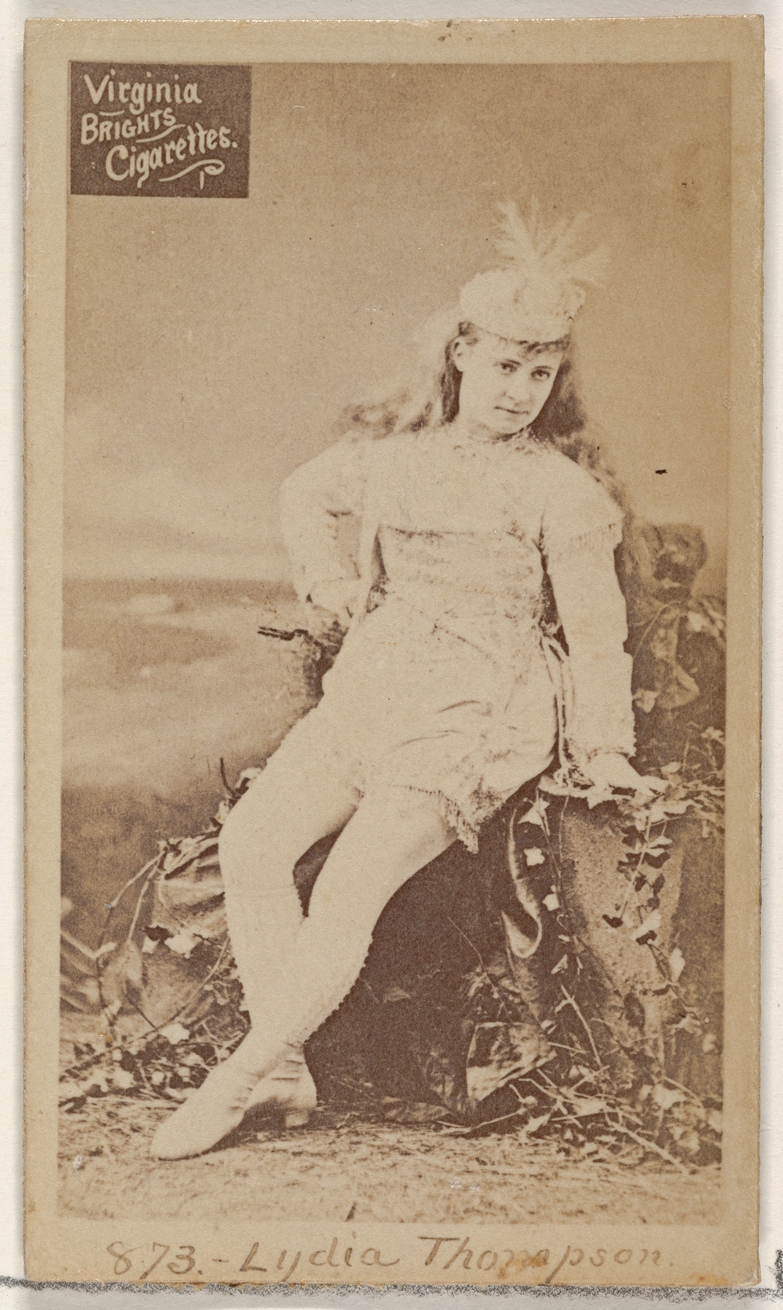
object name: photograph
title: Card 873, Lydia Thompson, from the Actors and Actresses series (N45, Type 2) for Virginia Brights Cigarettes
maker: allen & ginter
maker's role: publisher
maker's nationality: american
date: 1888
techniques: albumen silver print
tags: portraits,women,actresses